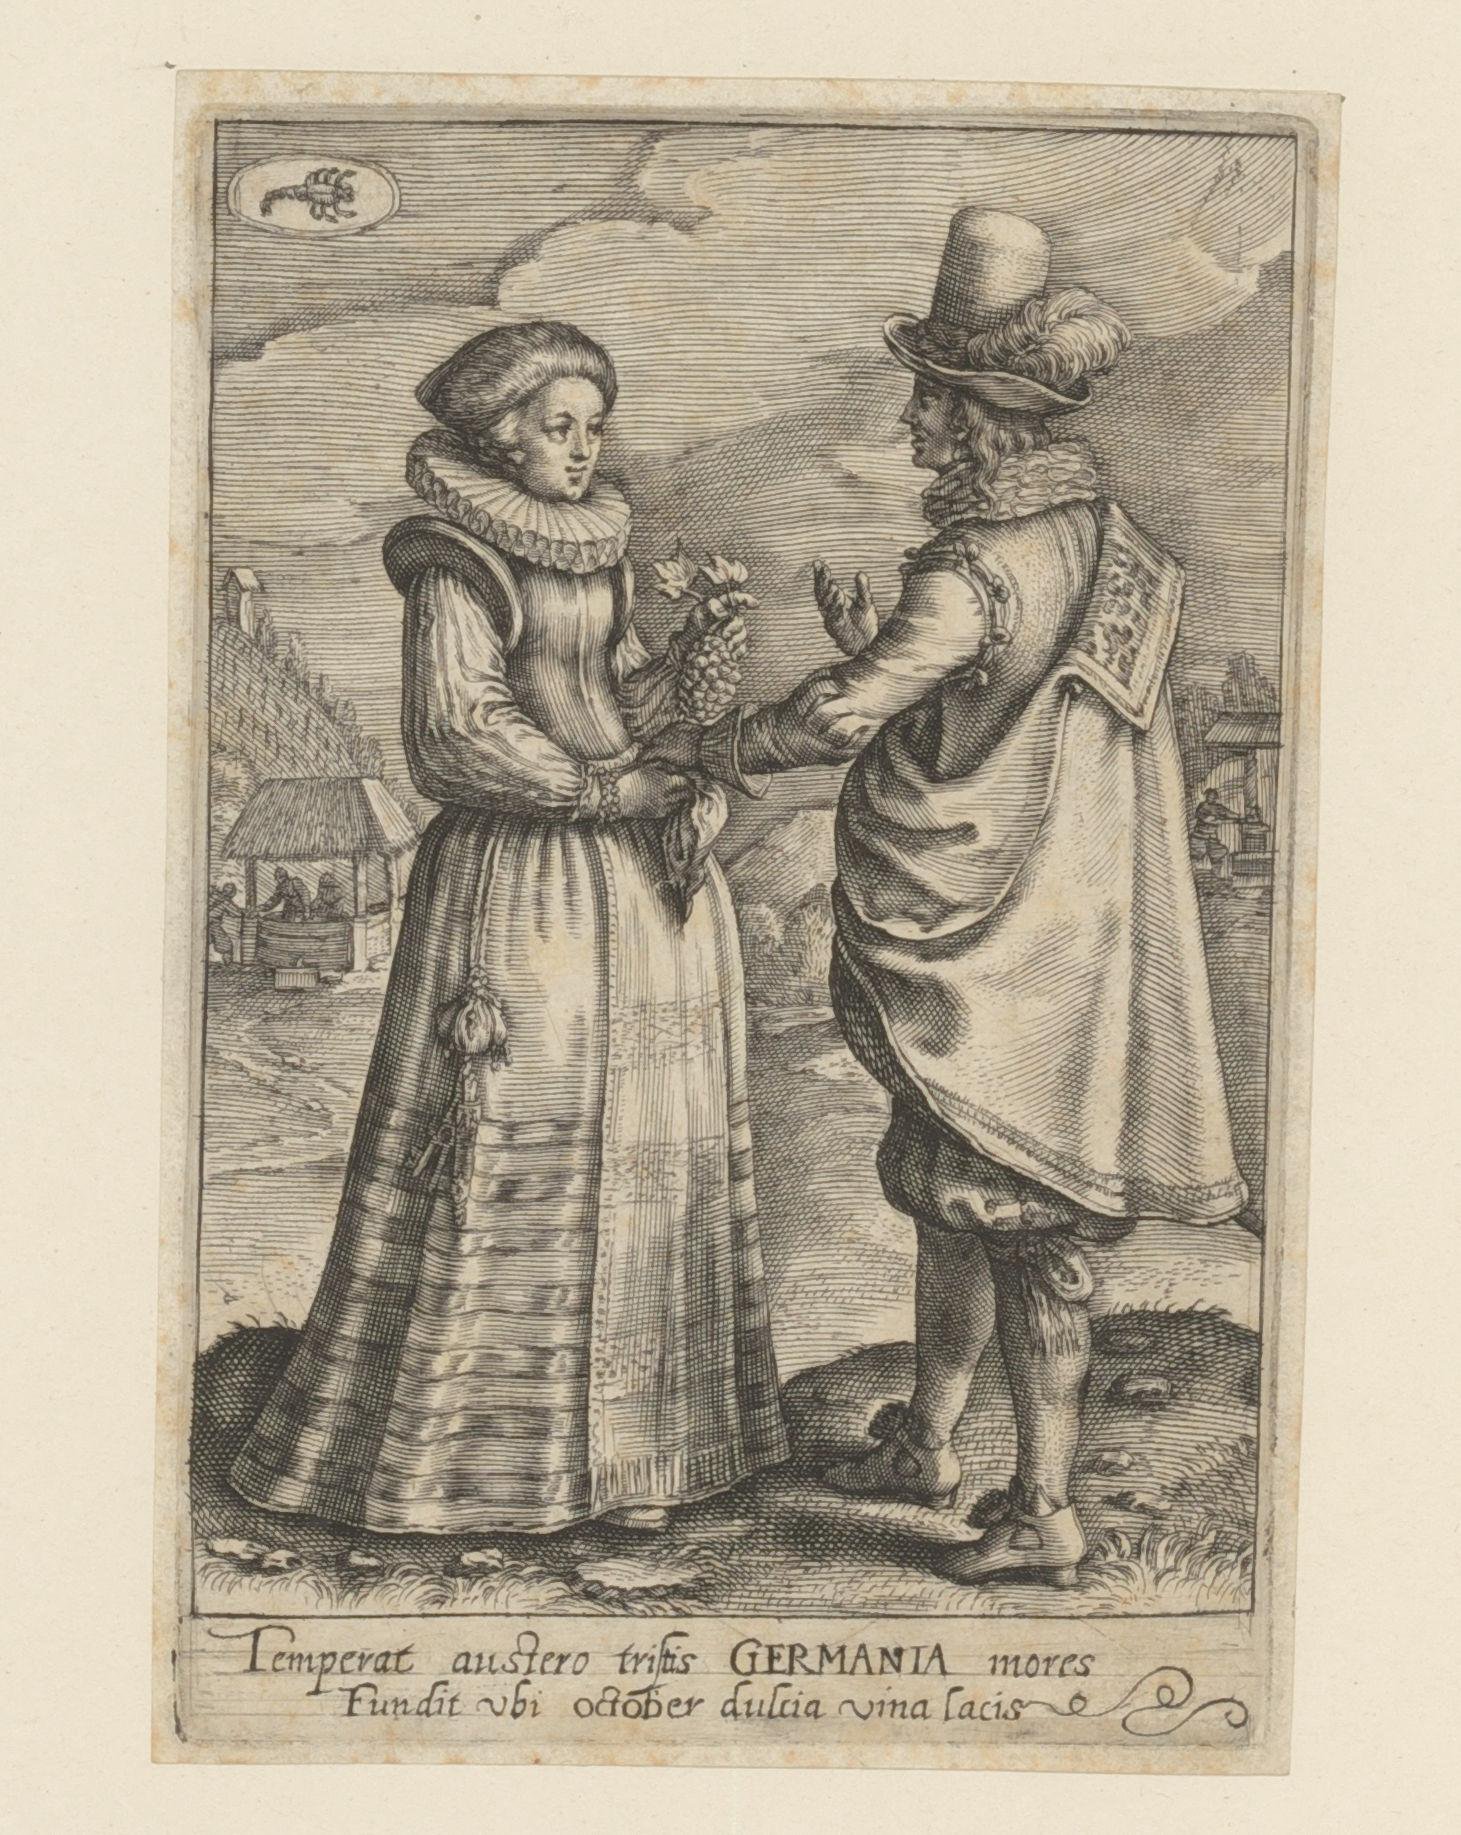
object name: print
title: De twaalf maanden met paren in kostuums uit verschillende landen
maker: crispijn van de passe (ii)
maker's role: draughtsman, print maker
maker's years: 1594-1670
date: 1620-1625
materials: paper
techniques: engraving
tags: taurus (zodiacal sign of april), other clothing accessories (keys) (+ women's clothes), other clothing accessories (purse) (+ women's clothes), clothes, costume (+ women's clothes), europeans: germans (+ costume), clothes, costume (+ men's clothes), shoes, sandals, trousers, breeches, etc. (breeches) (+ men's clothes), clothing for the upper part of the body (with name) (+ women's clothes), may ~ other concepts, germany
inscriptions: stamp:, collector's mark: Lugt 1641, collector's mark: Lugt 963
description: Man en vrouw, gekleed volgens de Duitse mode van ca. 1620. De vrouw houdt een tros druiven haar linkerhand en een zakdoek in haar rechterhand. De man maakt een spreekgebaar. Op de achtergrond een dorp met een waterput. Linksboven het teken van Schorpioen. In de marge een tweeregelig onderschrift in het Latijn over de wijn die in de maand oktober in Duitsland in overvloed aanwezig is. Prent uit een serie met de twaalf maanden weergegeven door tekens van de dierenriem en paren die kleding uit verschillende landen dragen. Onderwerpsrubrieken binnen de Atlas Zeden en Gewoonten: Zeden en Gewoonten in Engeren Zin, De Kleeding, Kleederdrachten (tijdvakken), Het begin der 17de eeuw. (De Fransche mode).